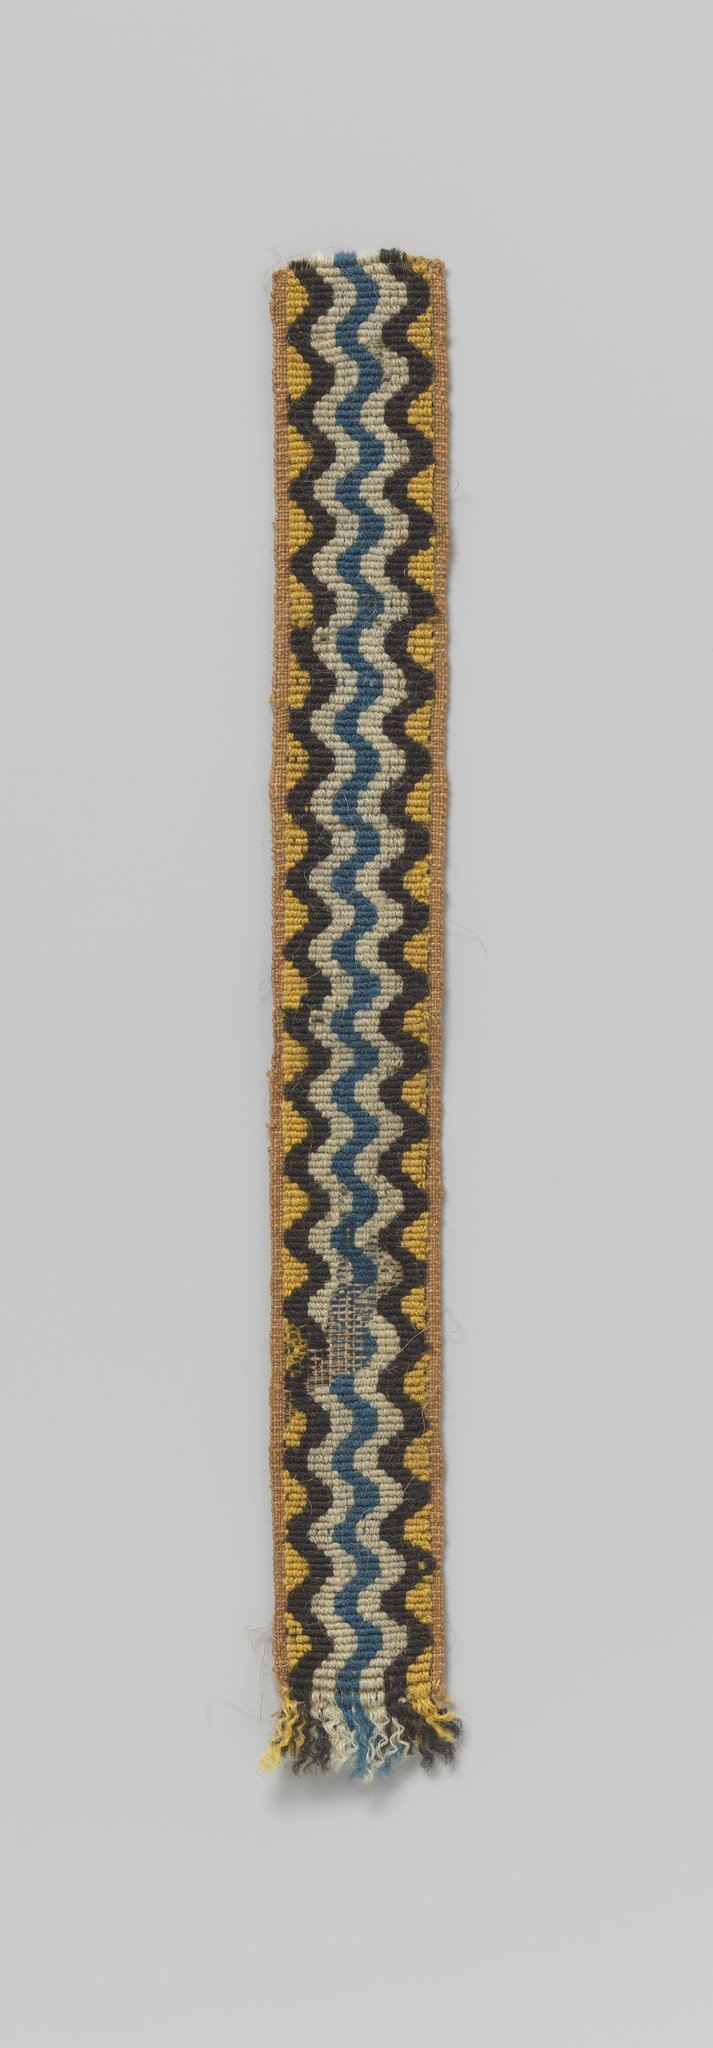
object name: passementerie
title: Livreiband van wol, geweven in golven in zwart, wit, geel en blauw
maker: Anonymous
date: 1700-1900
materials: linen, wool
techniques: weave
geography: netherlands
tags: amsterdam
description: Livreiband van wol, geweven in zwart, wit en blauw geslingerd op een geel fond. Lusjesweefsel van wol op een linnen ketting en inslag.